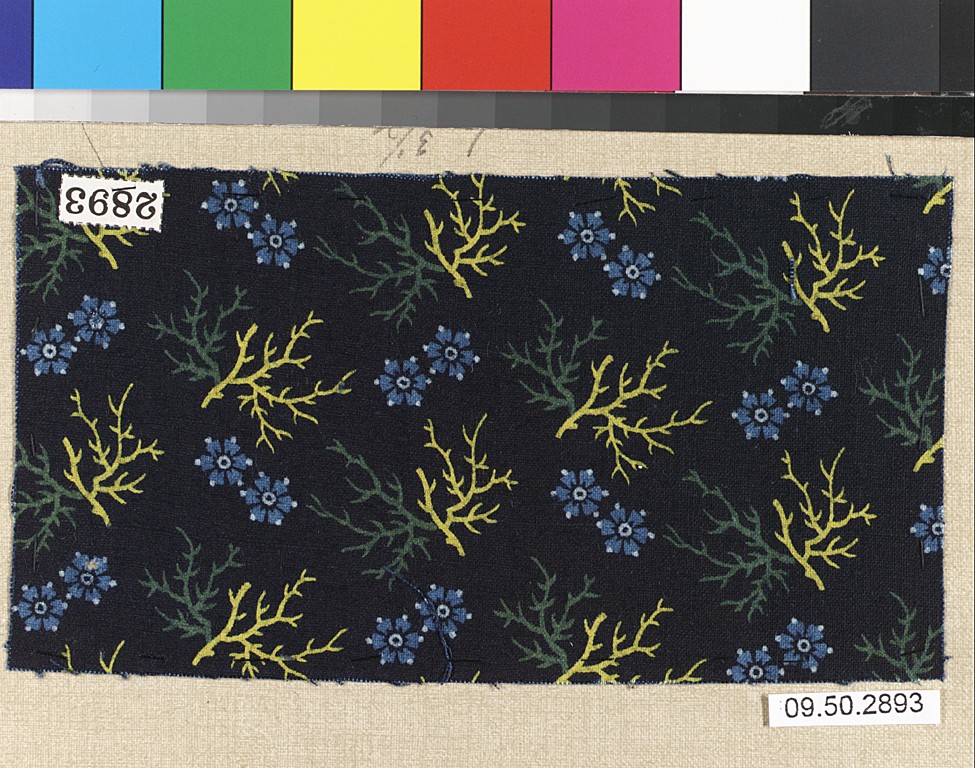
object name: piece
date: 1801-1900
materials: cotton